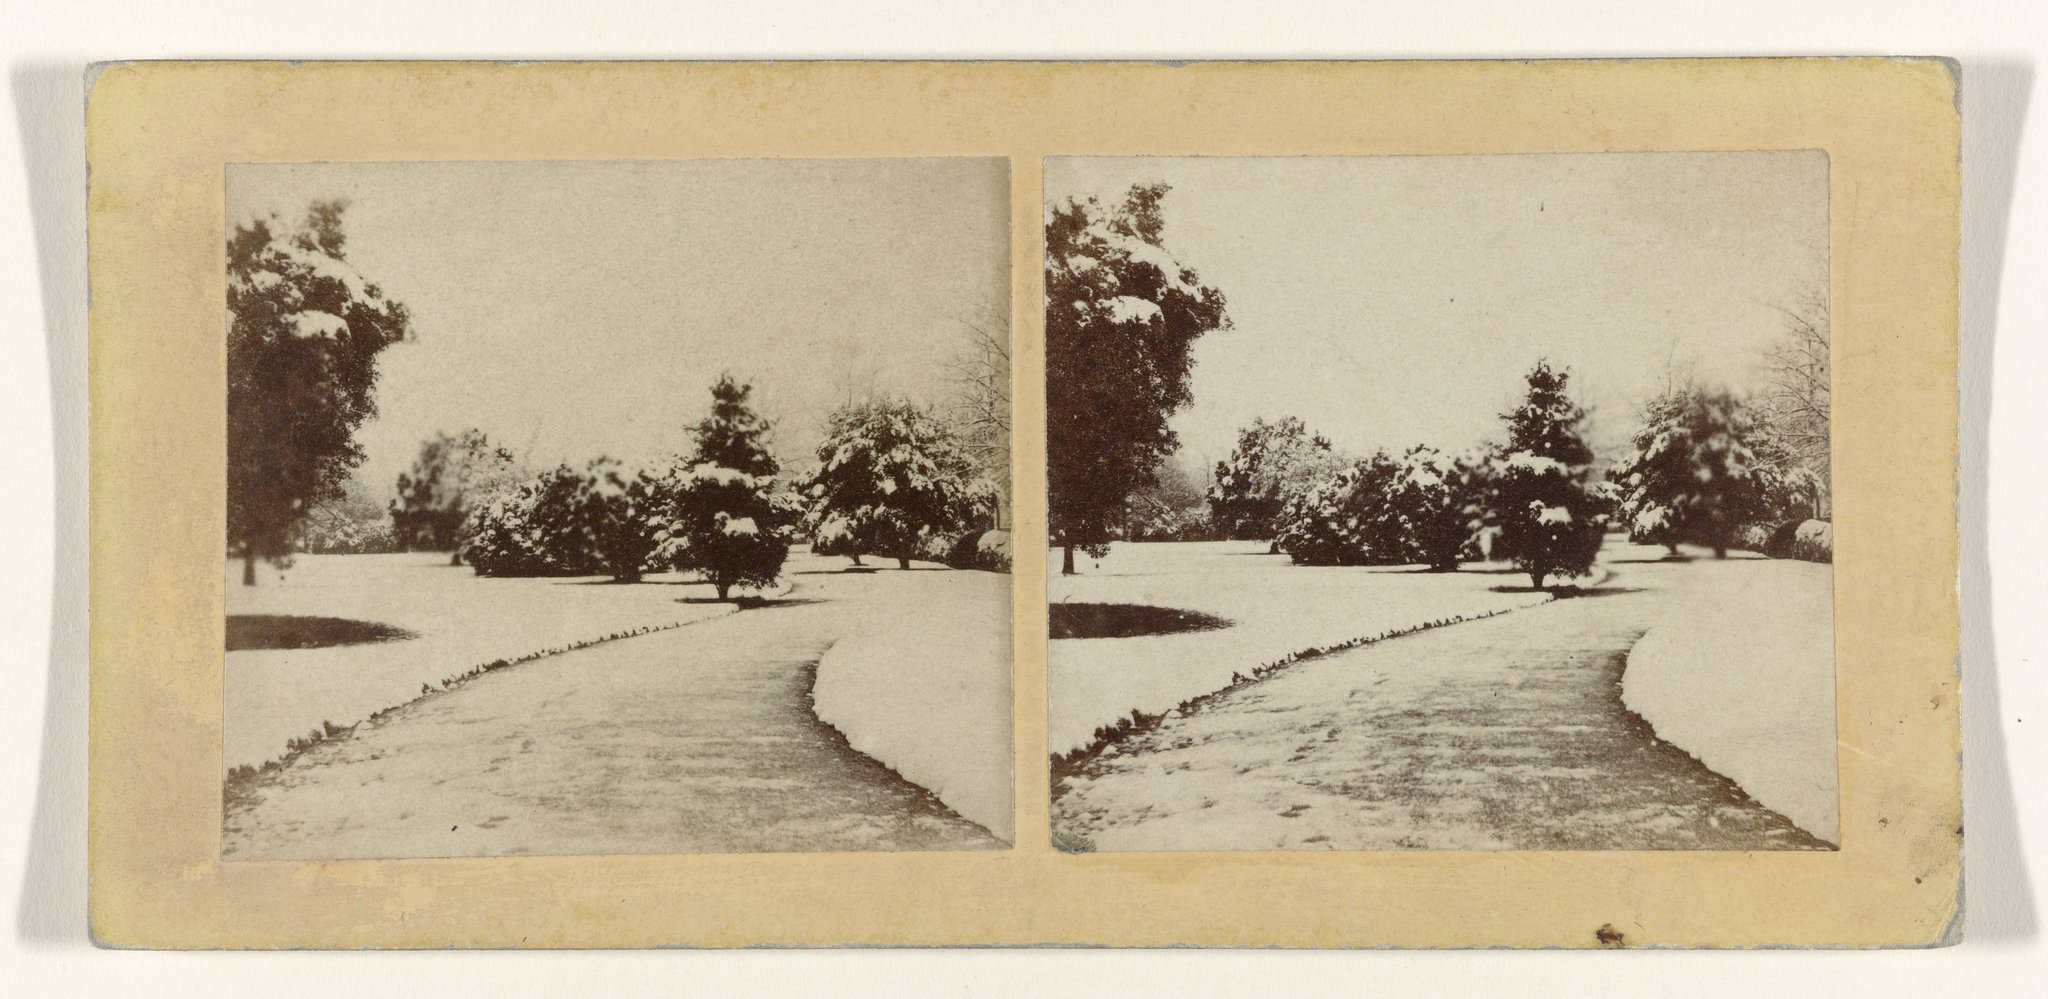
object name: stereograph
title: Sneeuwlandschap in Cheltenham, Engeland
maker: baynham jones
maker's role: fotograaf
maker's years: 1806-1890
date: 1861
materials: cardboard, paper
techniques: albumen print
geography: cheltenham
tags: brook, snow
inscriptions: inscription: ‘From/ Baynham Jones, Exp-, Selkirk Villa,/ Cheltenham’